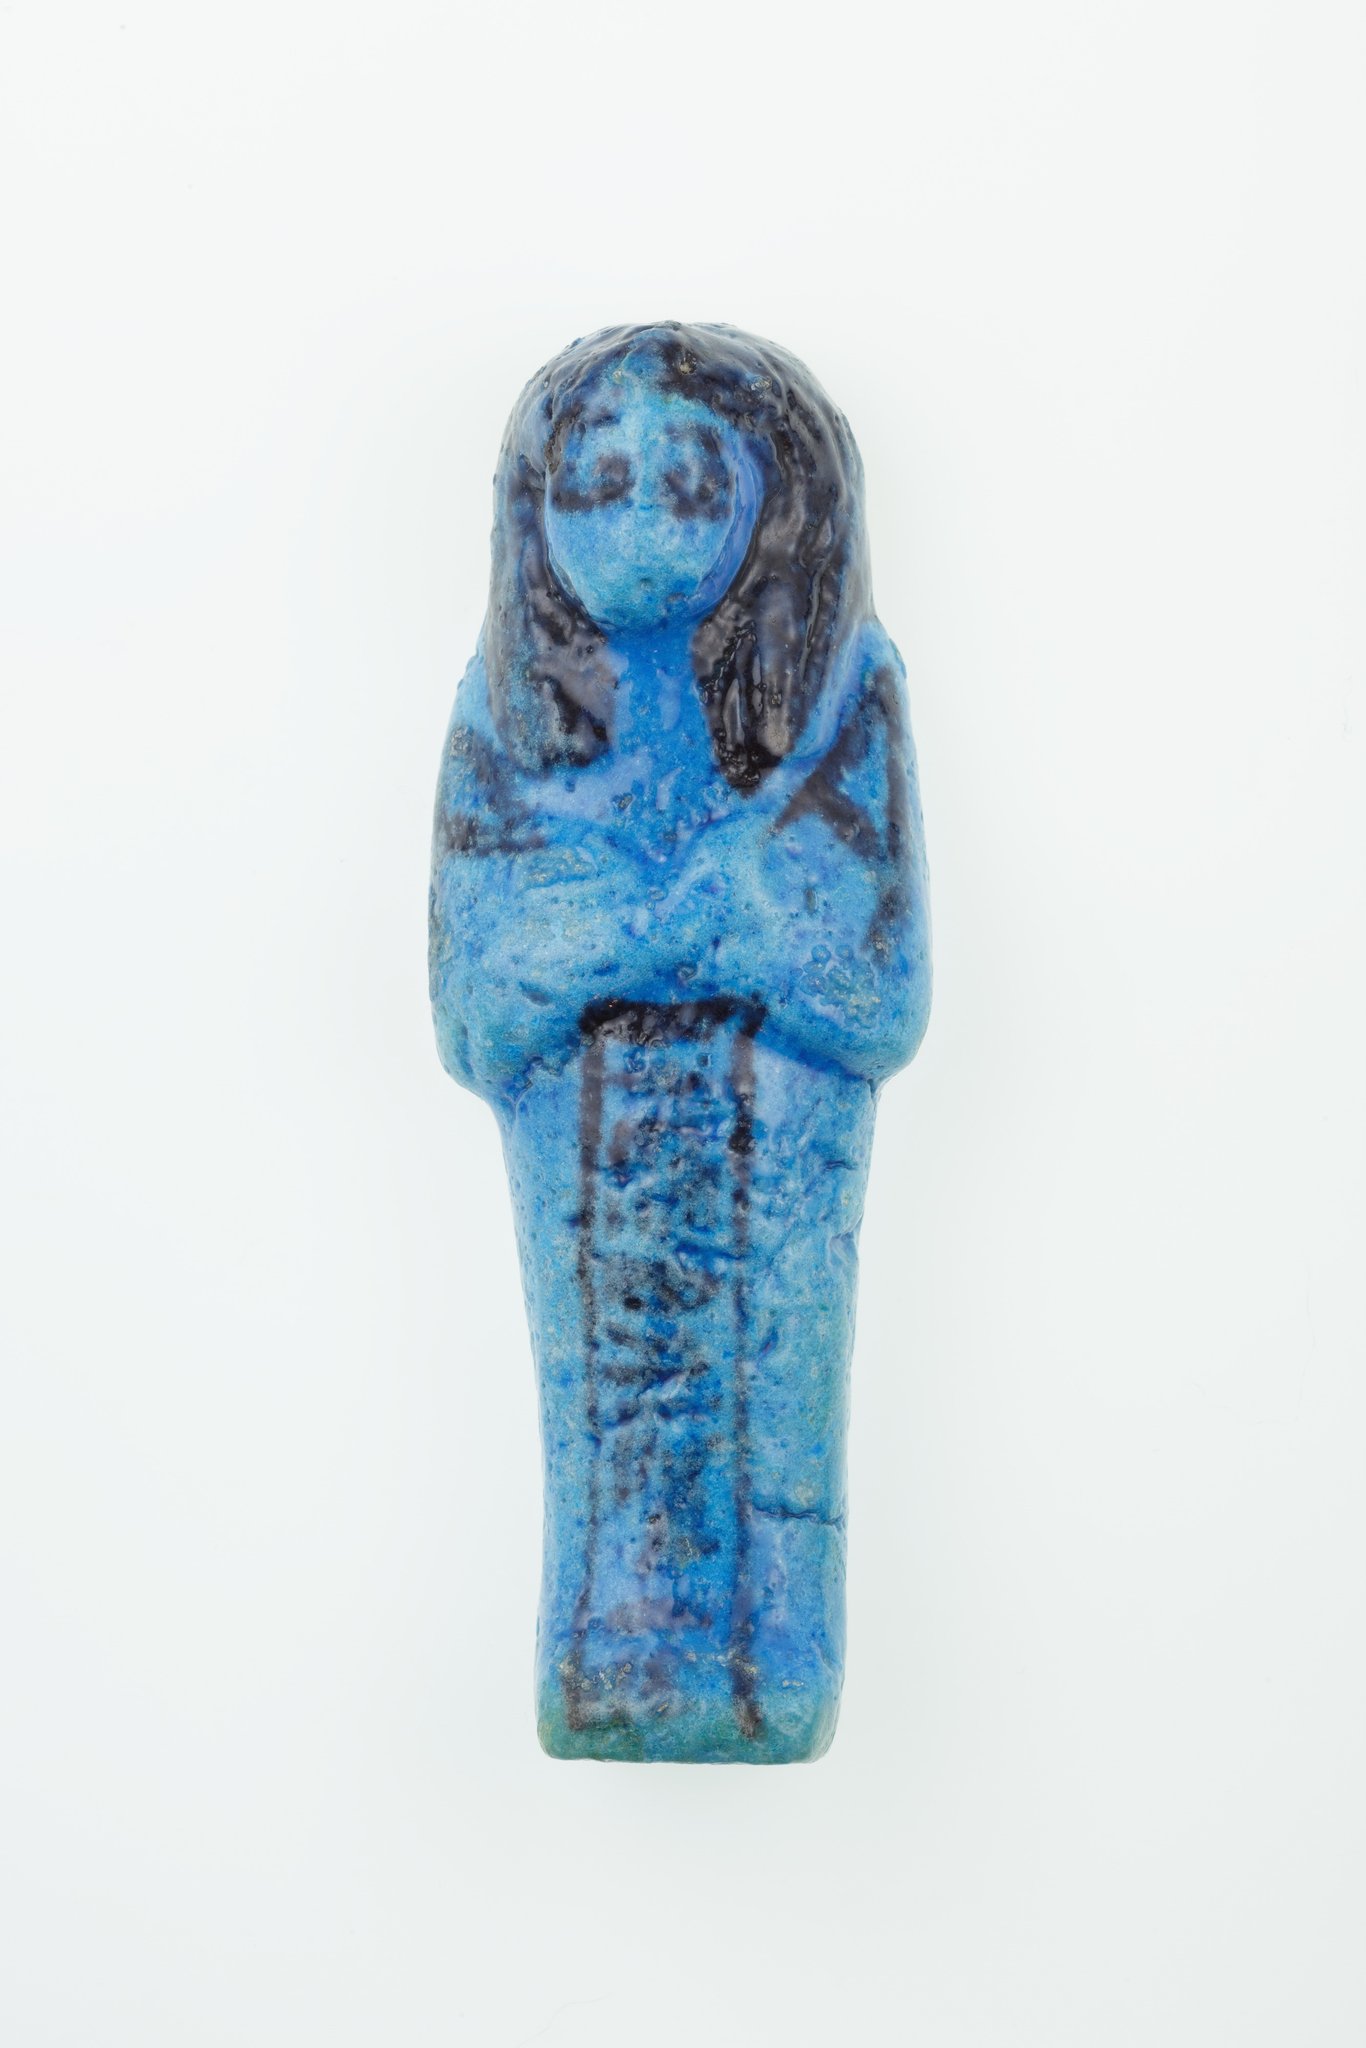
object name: shabti, worker, nauny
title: Worker Shabti of Nauny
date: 1050 BCE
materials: faience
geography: egypt